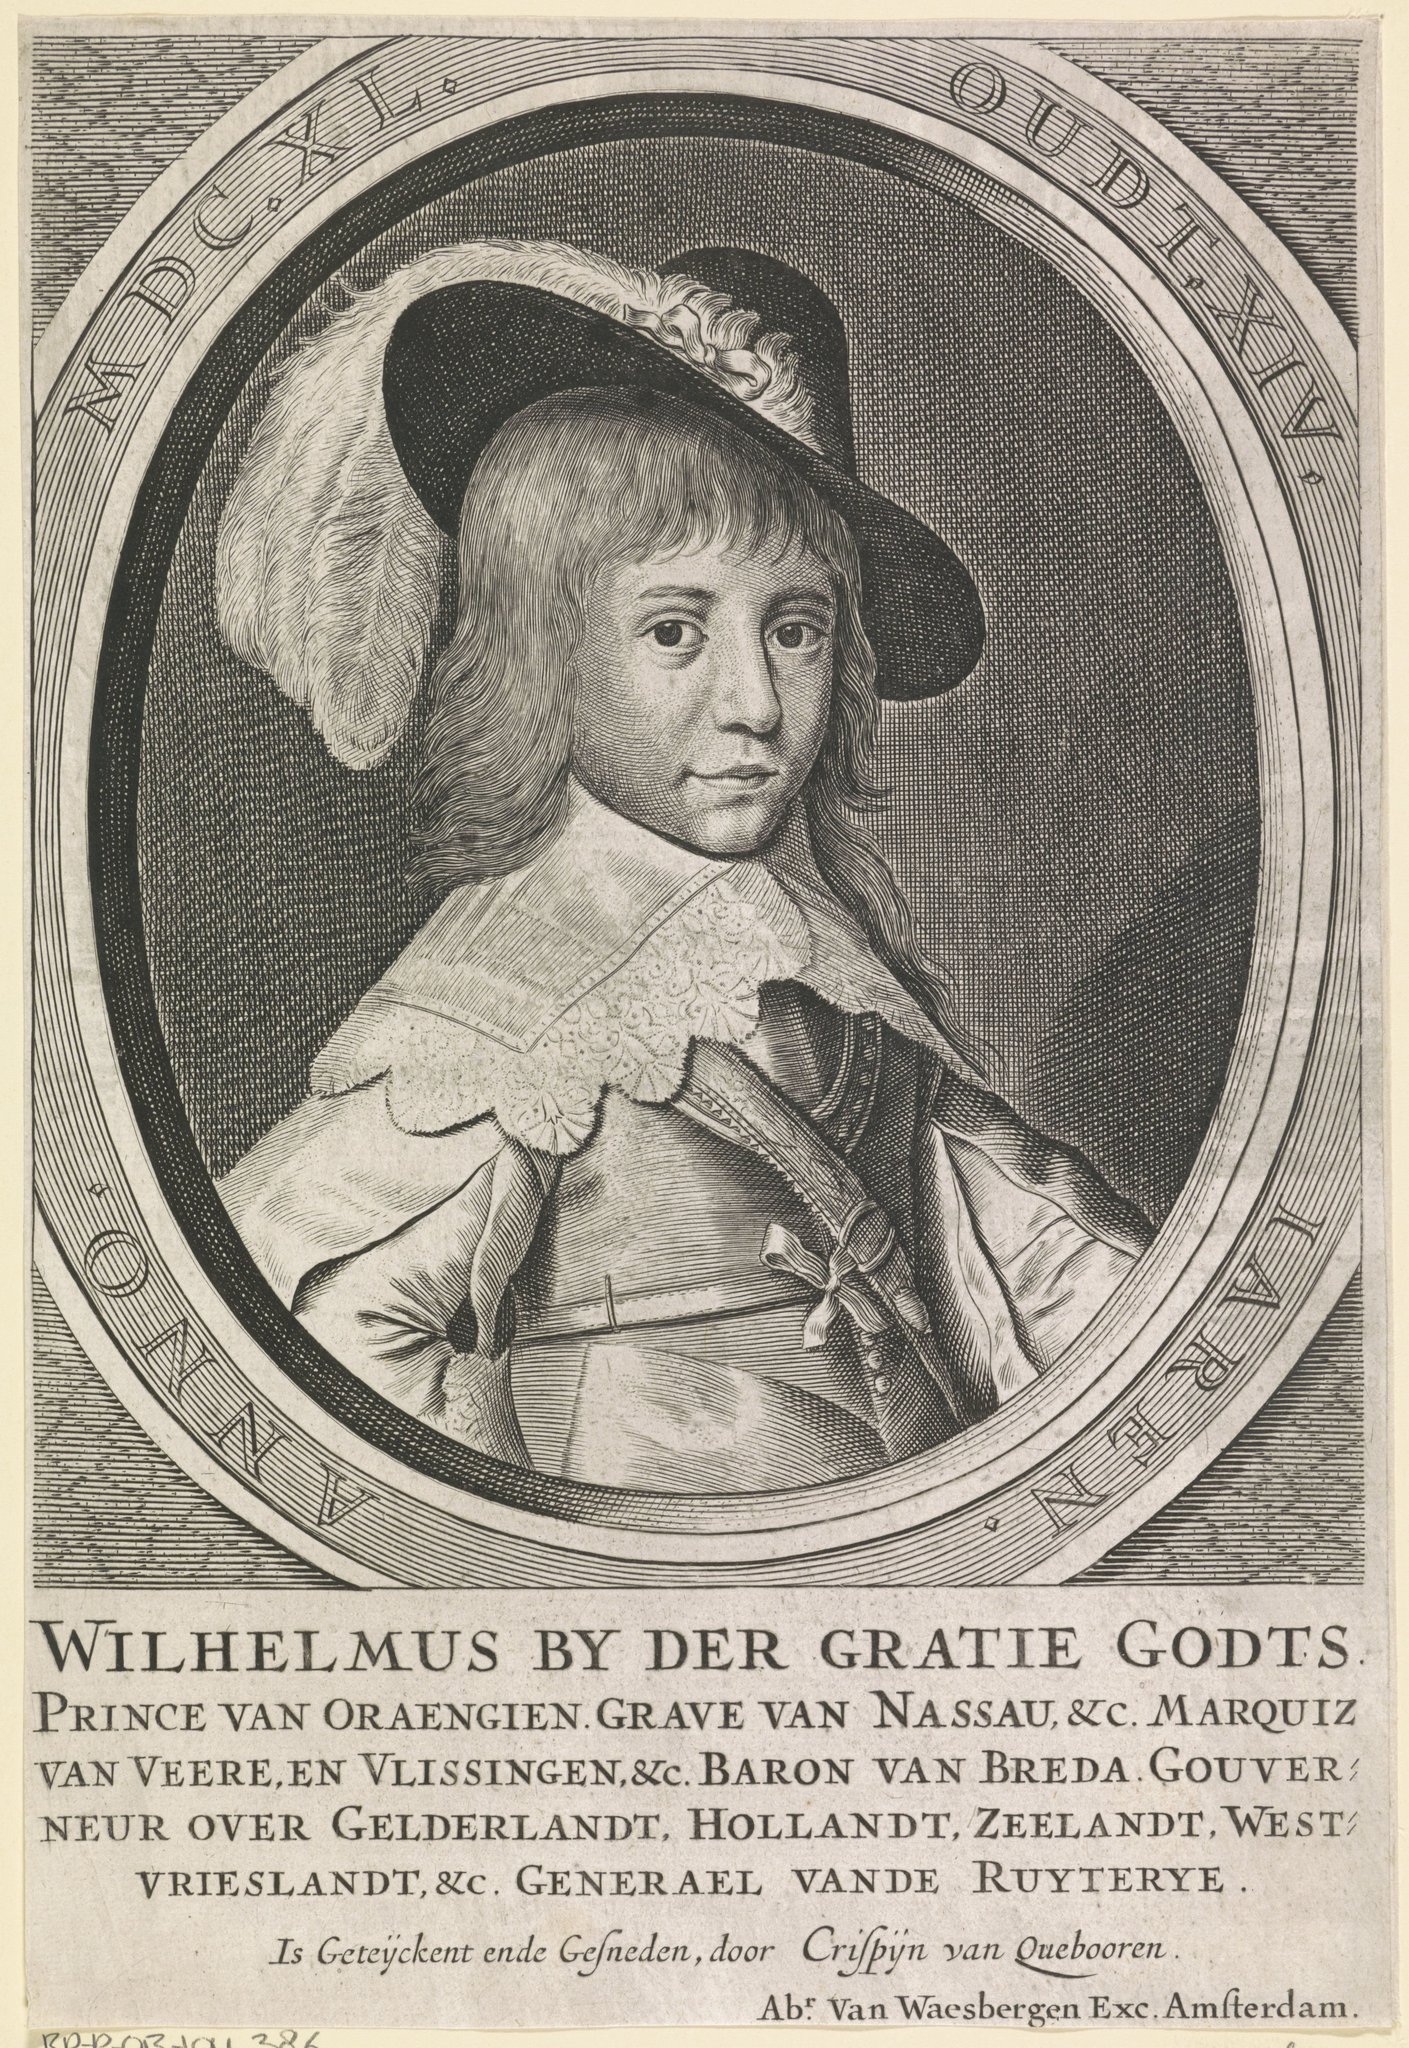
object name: print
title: Portret van Willem II, prins van Oranje, op 14-jarige leeftijd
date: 1640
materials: paper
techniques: engraving, etching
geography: amsterdam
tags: william ii (prince of orange)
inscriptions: date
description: De hier vermelde titel verwijst naar de hoogst verkregen titel van de geportretteerde, niet per se naar de titel die de geportretteerde op deze voorstelling draagt.